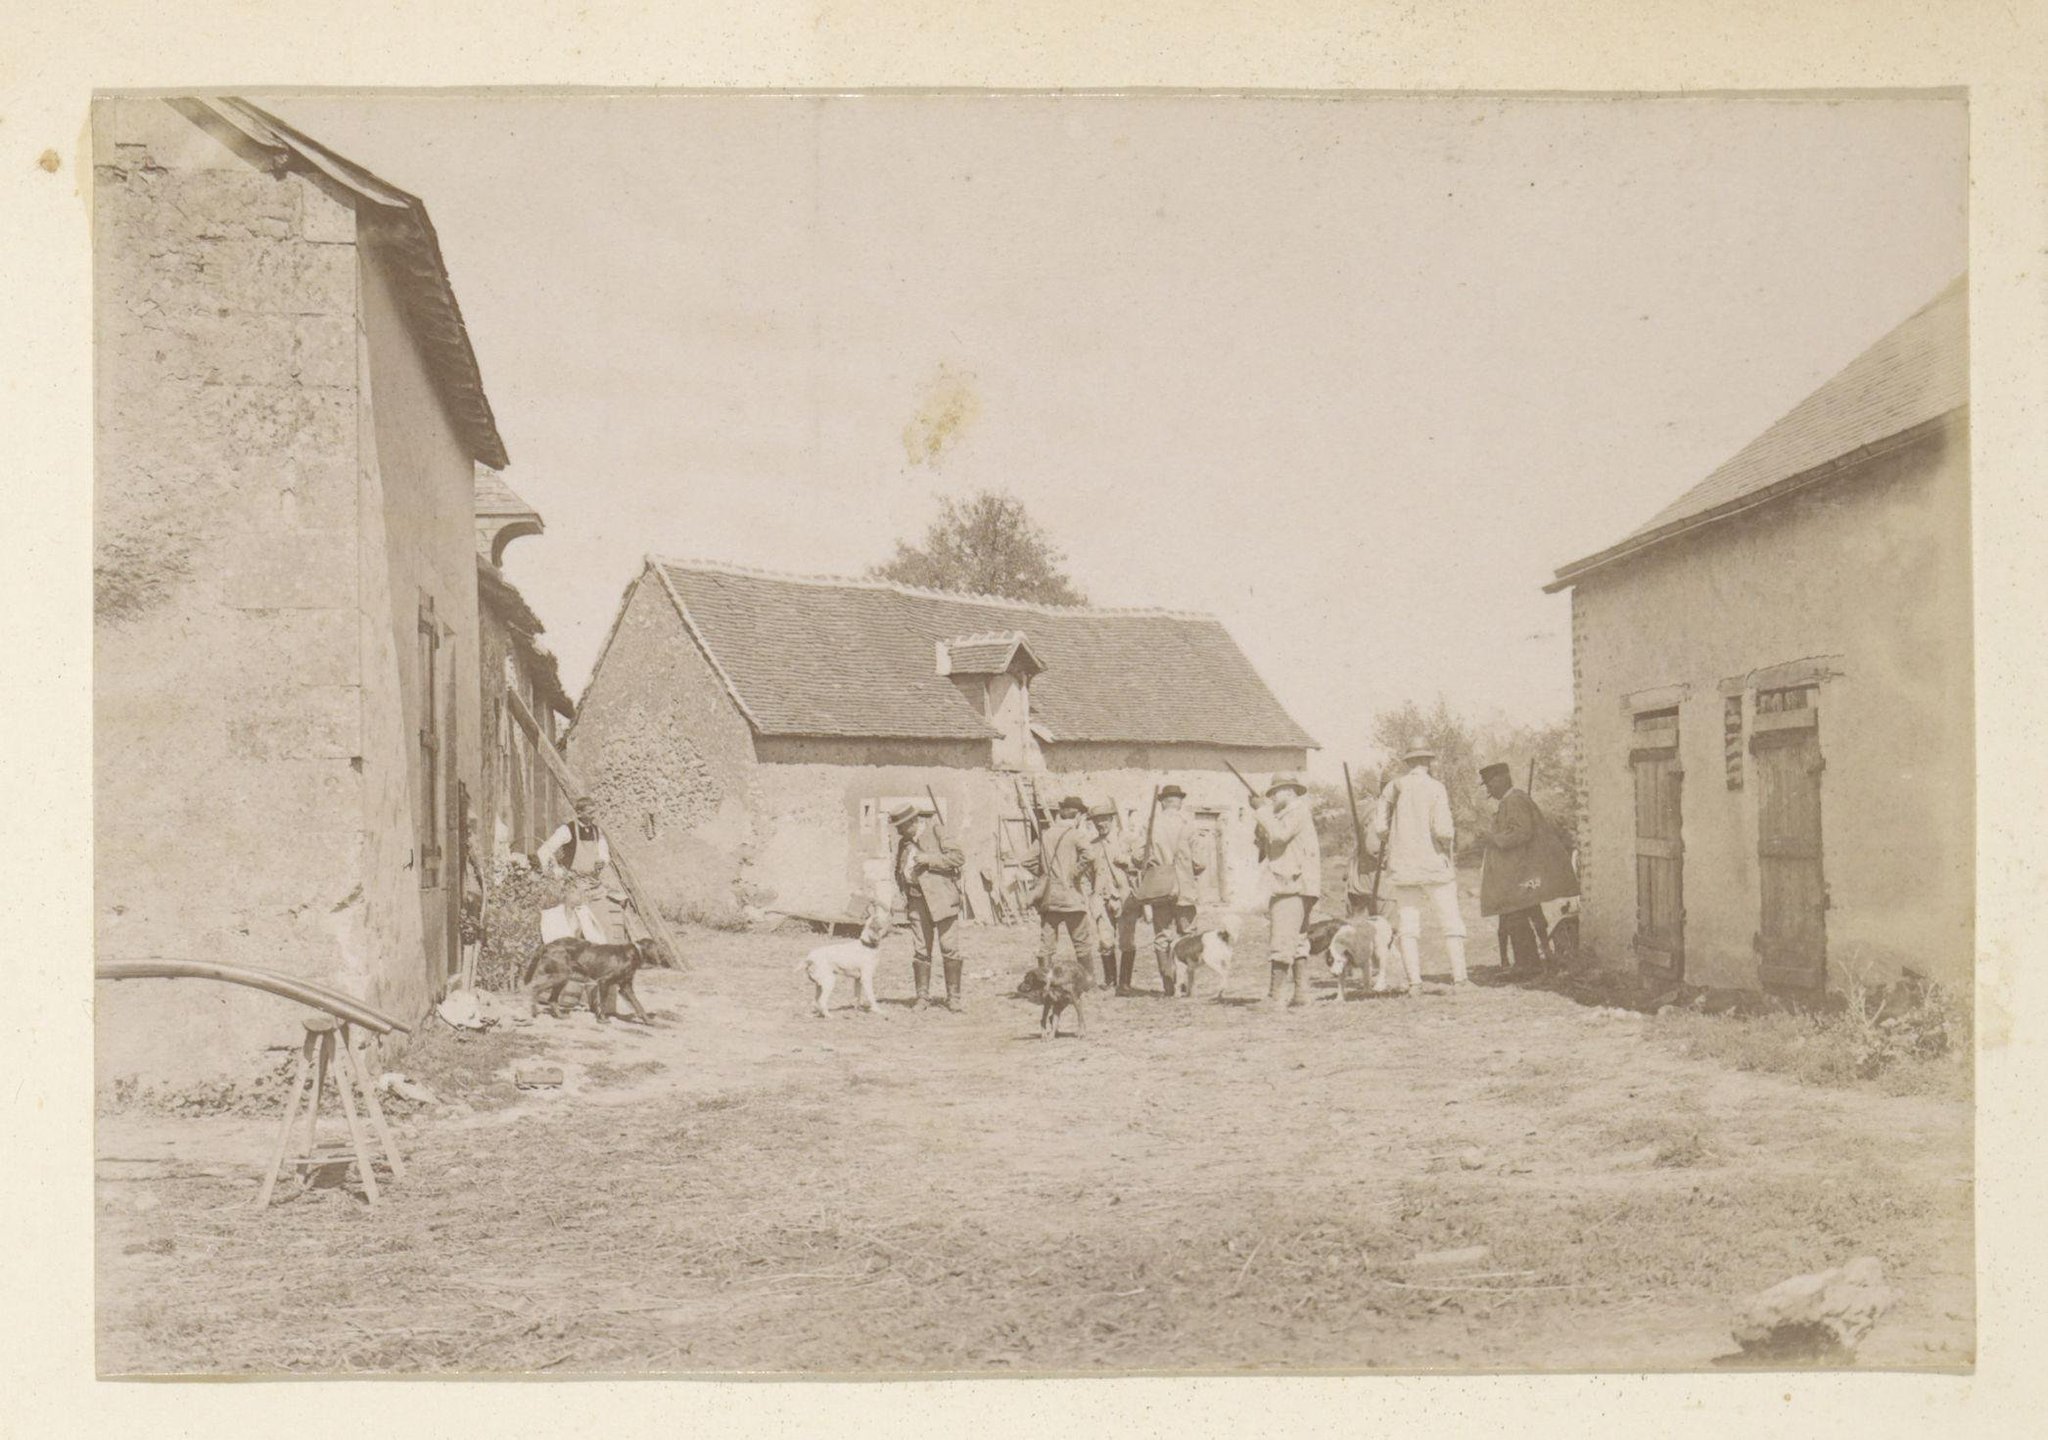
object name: photograph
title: Groepsportret van een jachtgezelschap op een erf in Frankrijk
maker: Anonymous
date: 1900-1910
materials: paper, photographic support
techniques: albumen print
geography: france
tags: group-portrait of hunters, hunting dogs, farm (building), france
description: Onderdeel van Fotoalbum van een Franse amateurfotograaf met opnames van een familie, distilleerderij Delizy & Doistau Fils, het leger en bezienswaardigheden in Frankrijk.